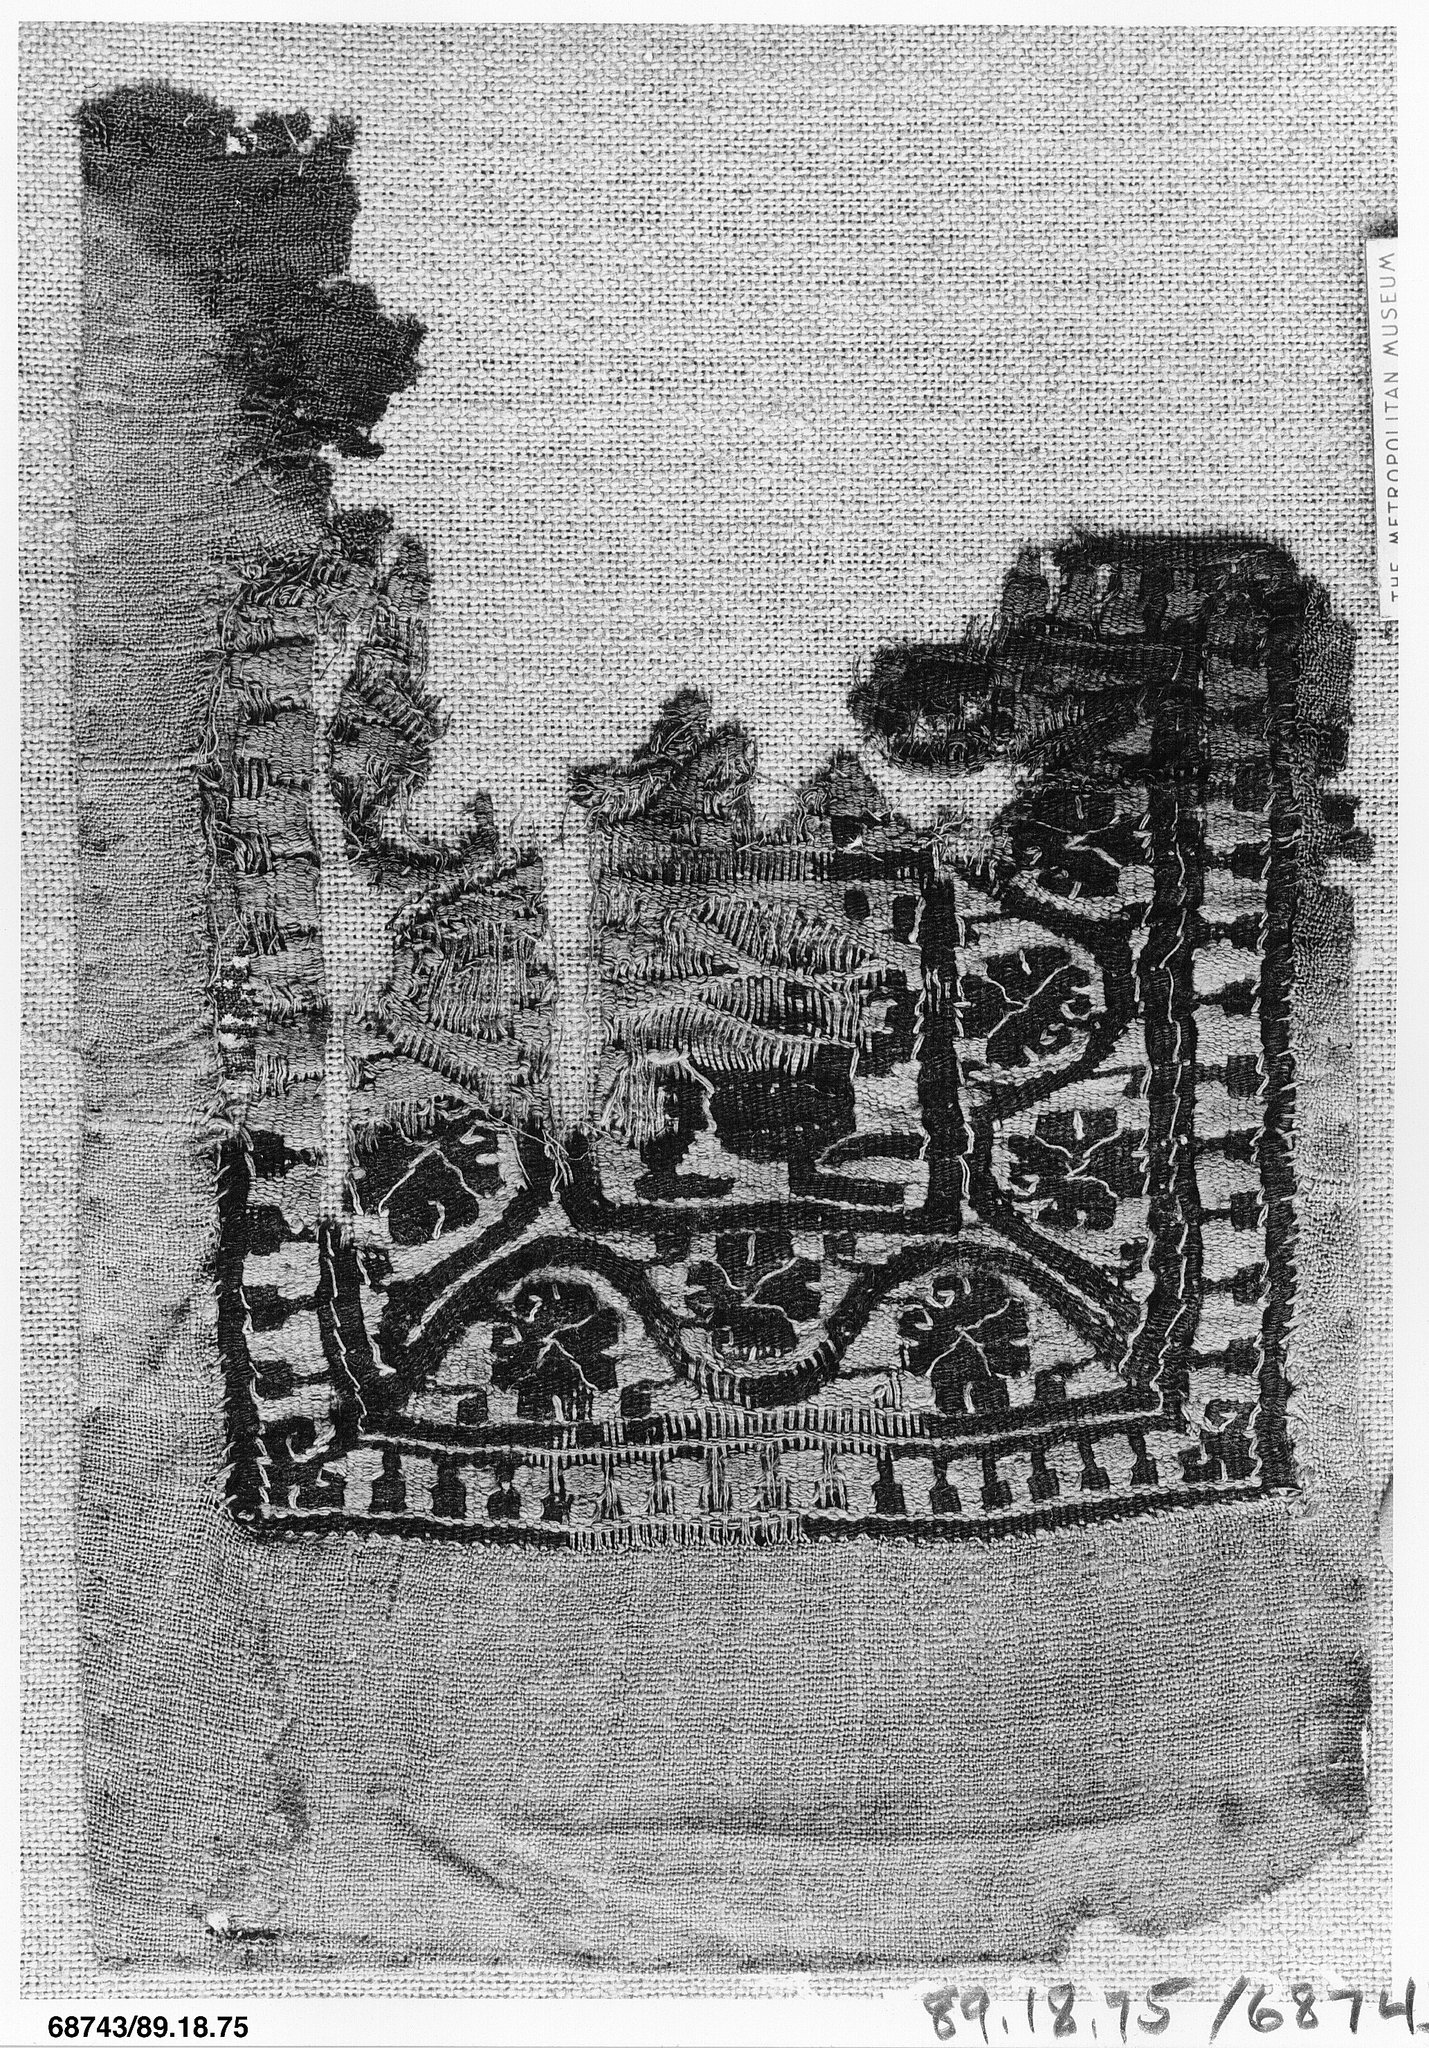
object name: textile fragment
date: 201-400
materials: linen, wool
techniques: weave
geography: egypt